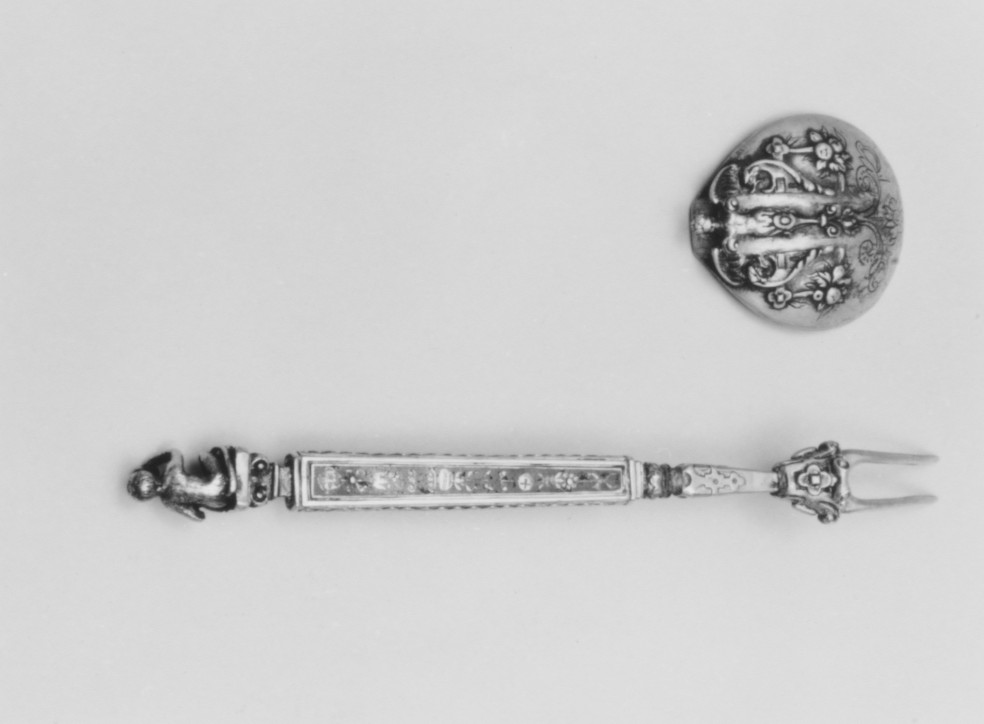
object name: spoon and fork combination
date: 1851-1900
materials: niello, silver gilt